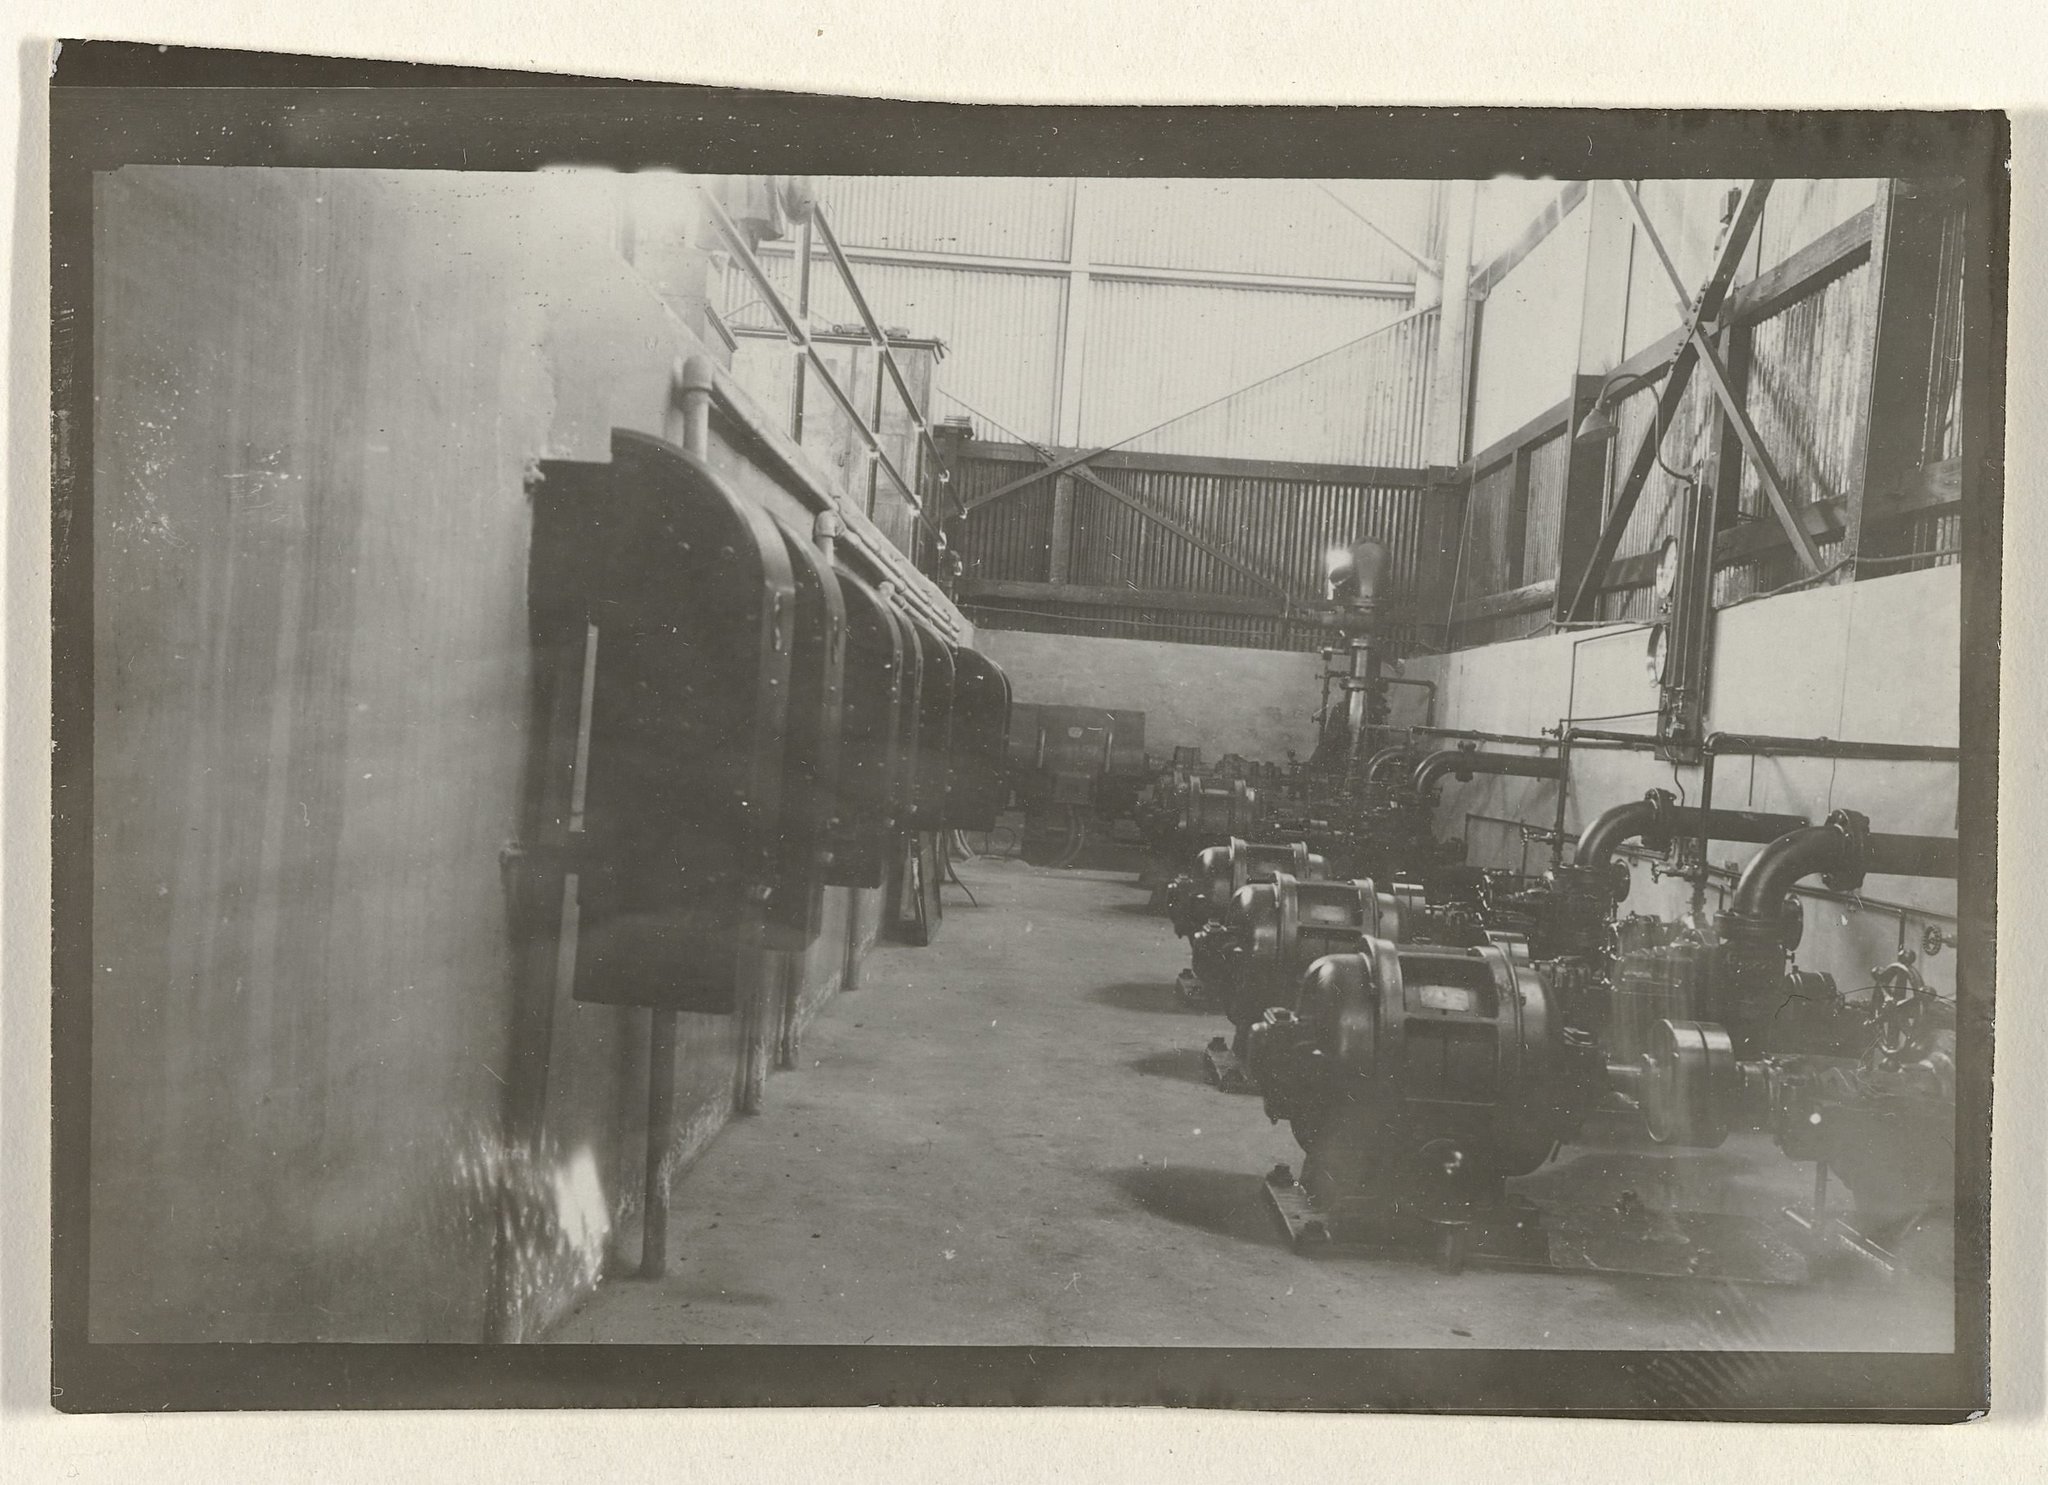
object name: photograph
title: Waterpompen in de elektriciteitcentrale in Moengo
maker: Anonymous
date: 1929-1930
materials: photographic support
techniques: photography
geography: suriname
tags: opencast mine; strip mining